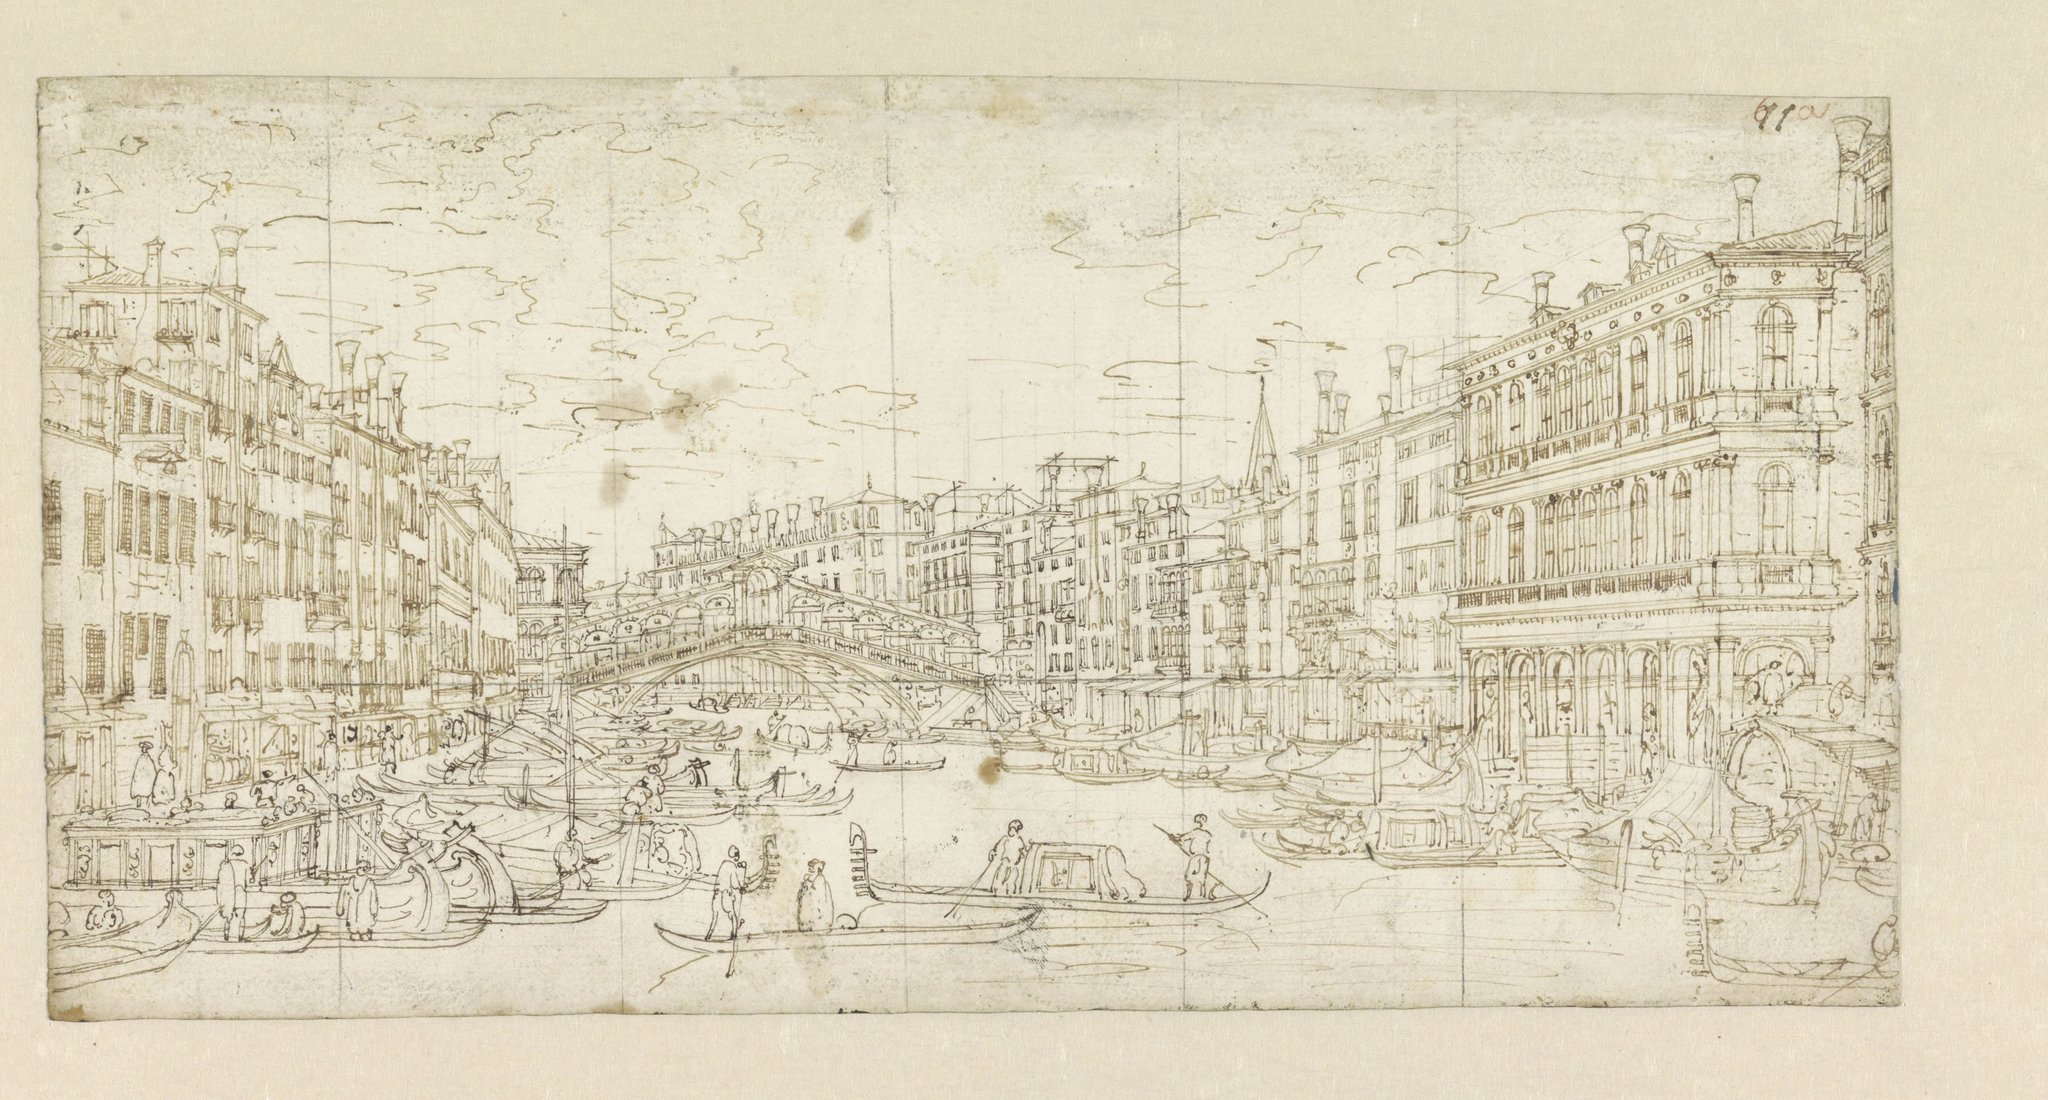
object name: drawing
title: Gezicht op de Canal Grande en Ponte del Rialto te Venetië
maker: bernardo bellotto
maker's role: draughtsman, painter, print maker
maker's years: 1721-1780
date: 1730-1780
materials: ink, paper, pencil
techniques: pen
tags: canals, waters (in city), bridge in city across river, canal, etc., public road, italy, venice